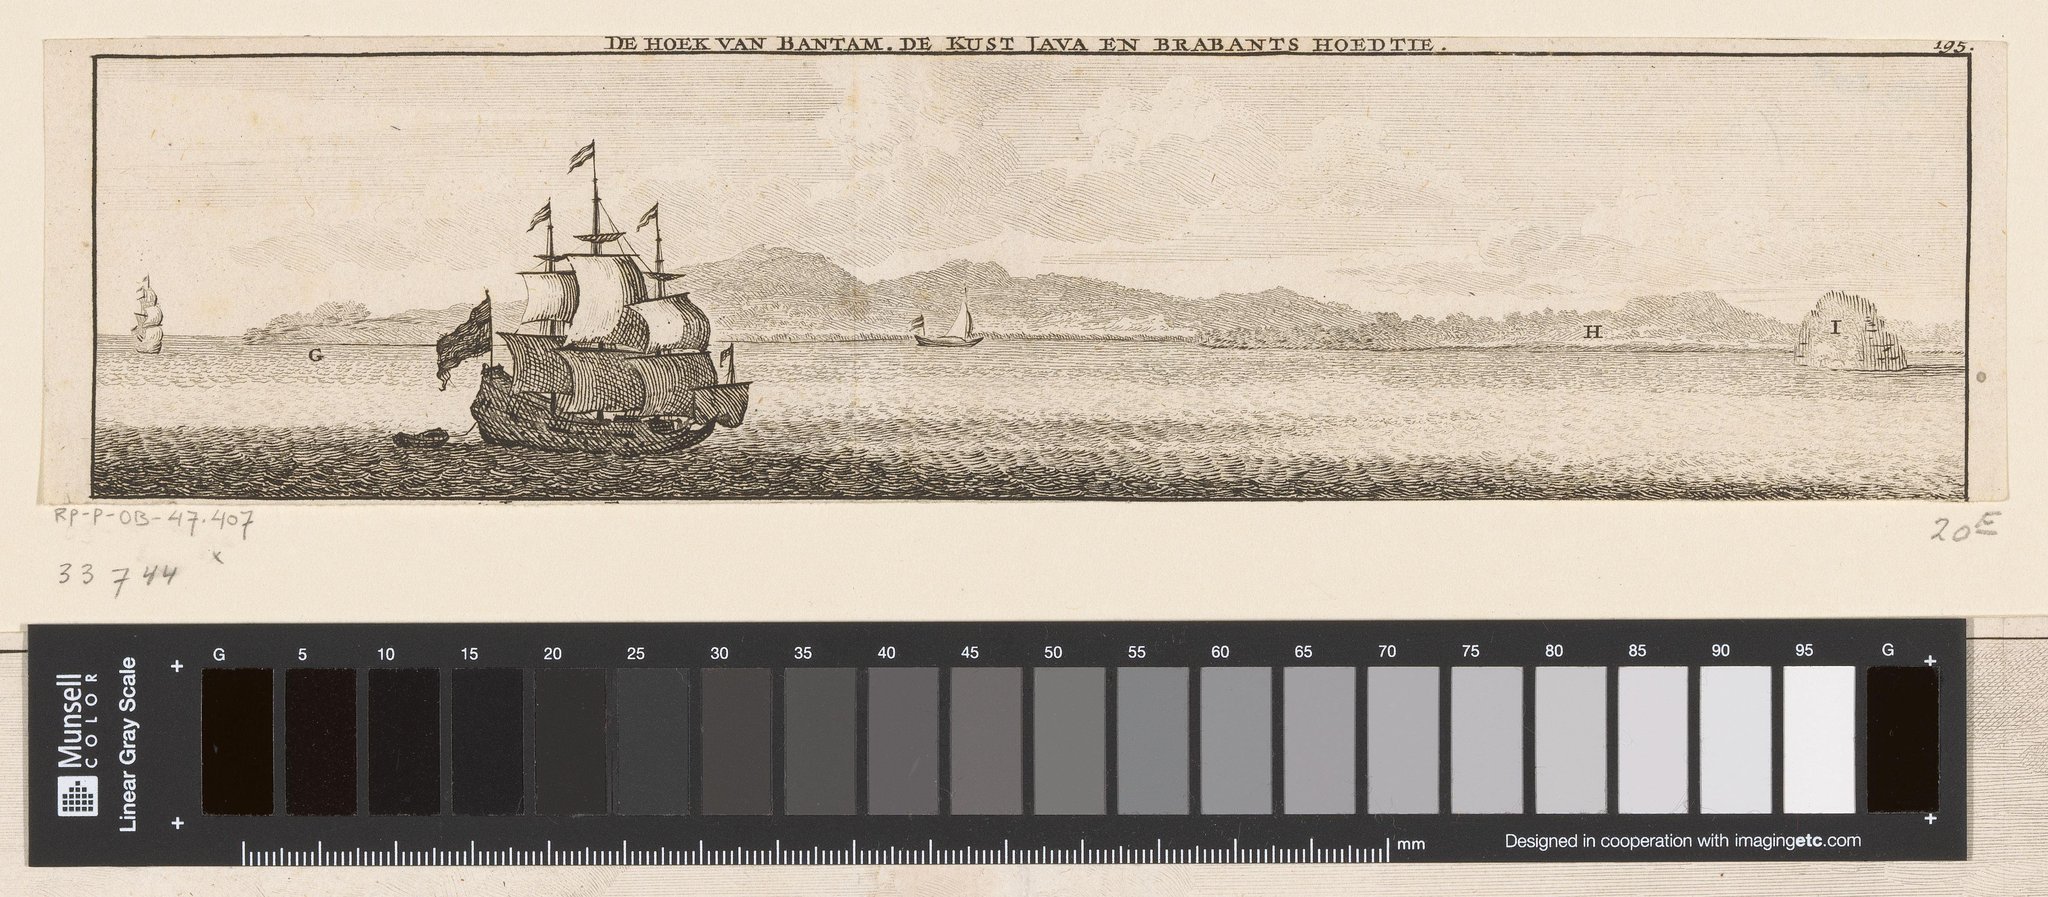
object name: print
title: De hoek van Bantam, de Kust Java en Brabants hoedtie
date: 1714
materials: paper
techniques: engraving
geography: amsterdam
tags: sailing-ship, sailing-boat, landscapes with waters, waterscapes, seascapes (in the temperate zone), coast, java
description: Fragment van een prent afkomstig uit: Bruin, Cornelis de. Reizen over Moskovie door Persie en Indie. Amsterdam: Rudolph & Gerard Wetstein, Johannes van Oosterwyk, Hendrik van de Gaete, 1714.